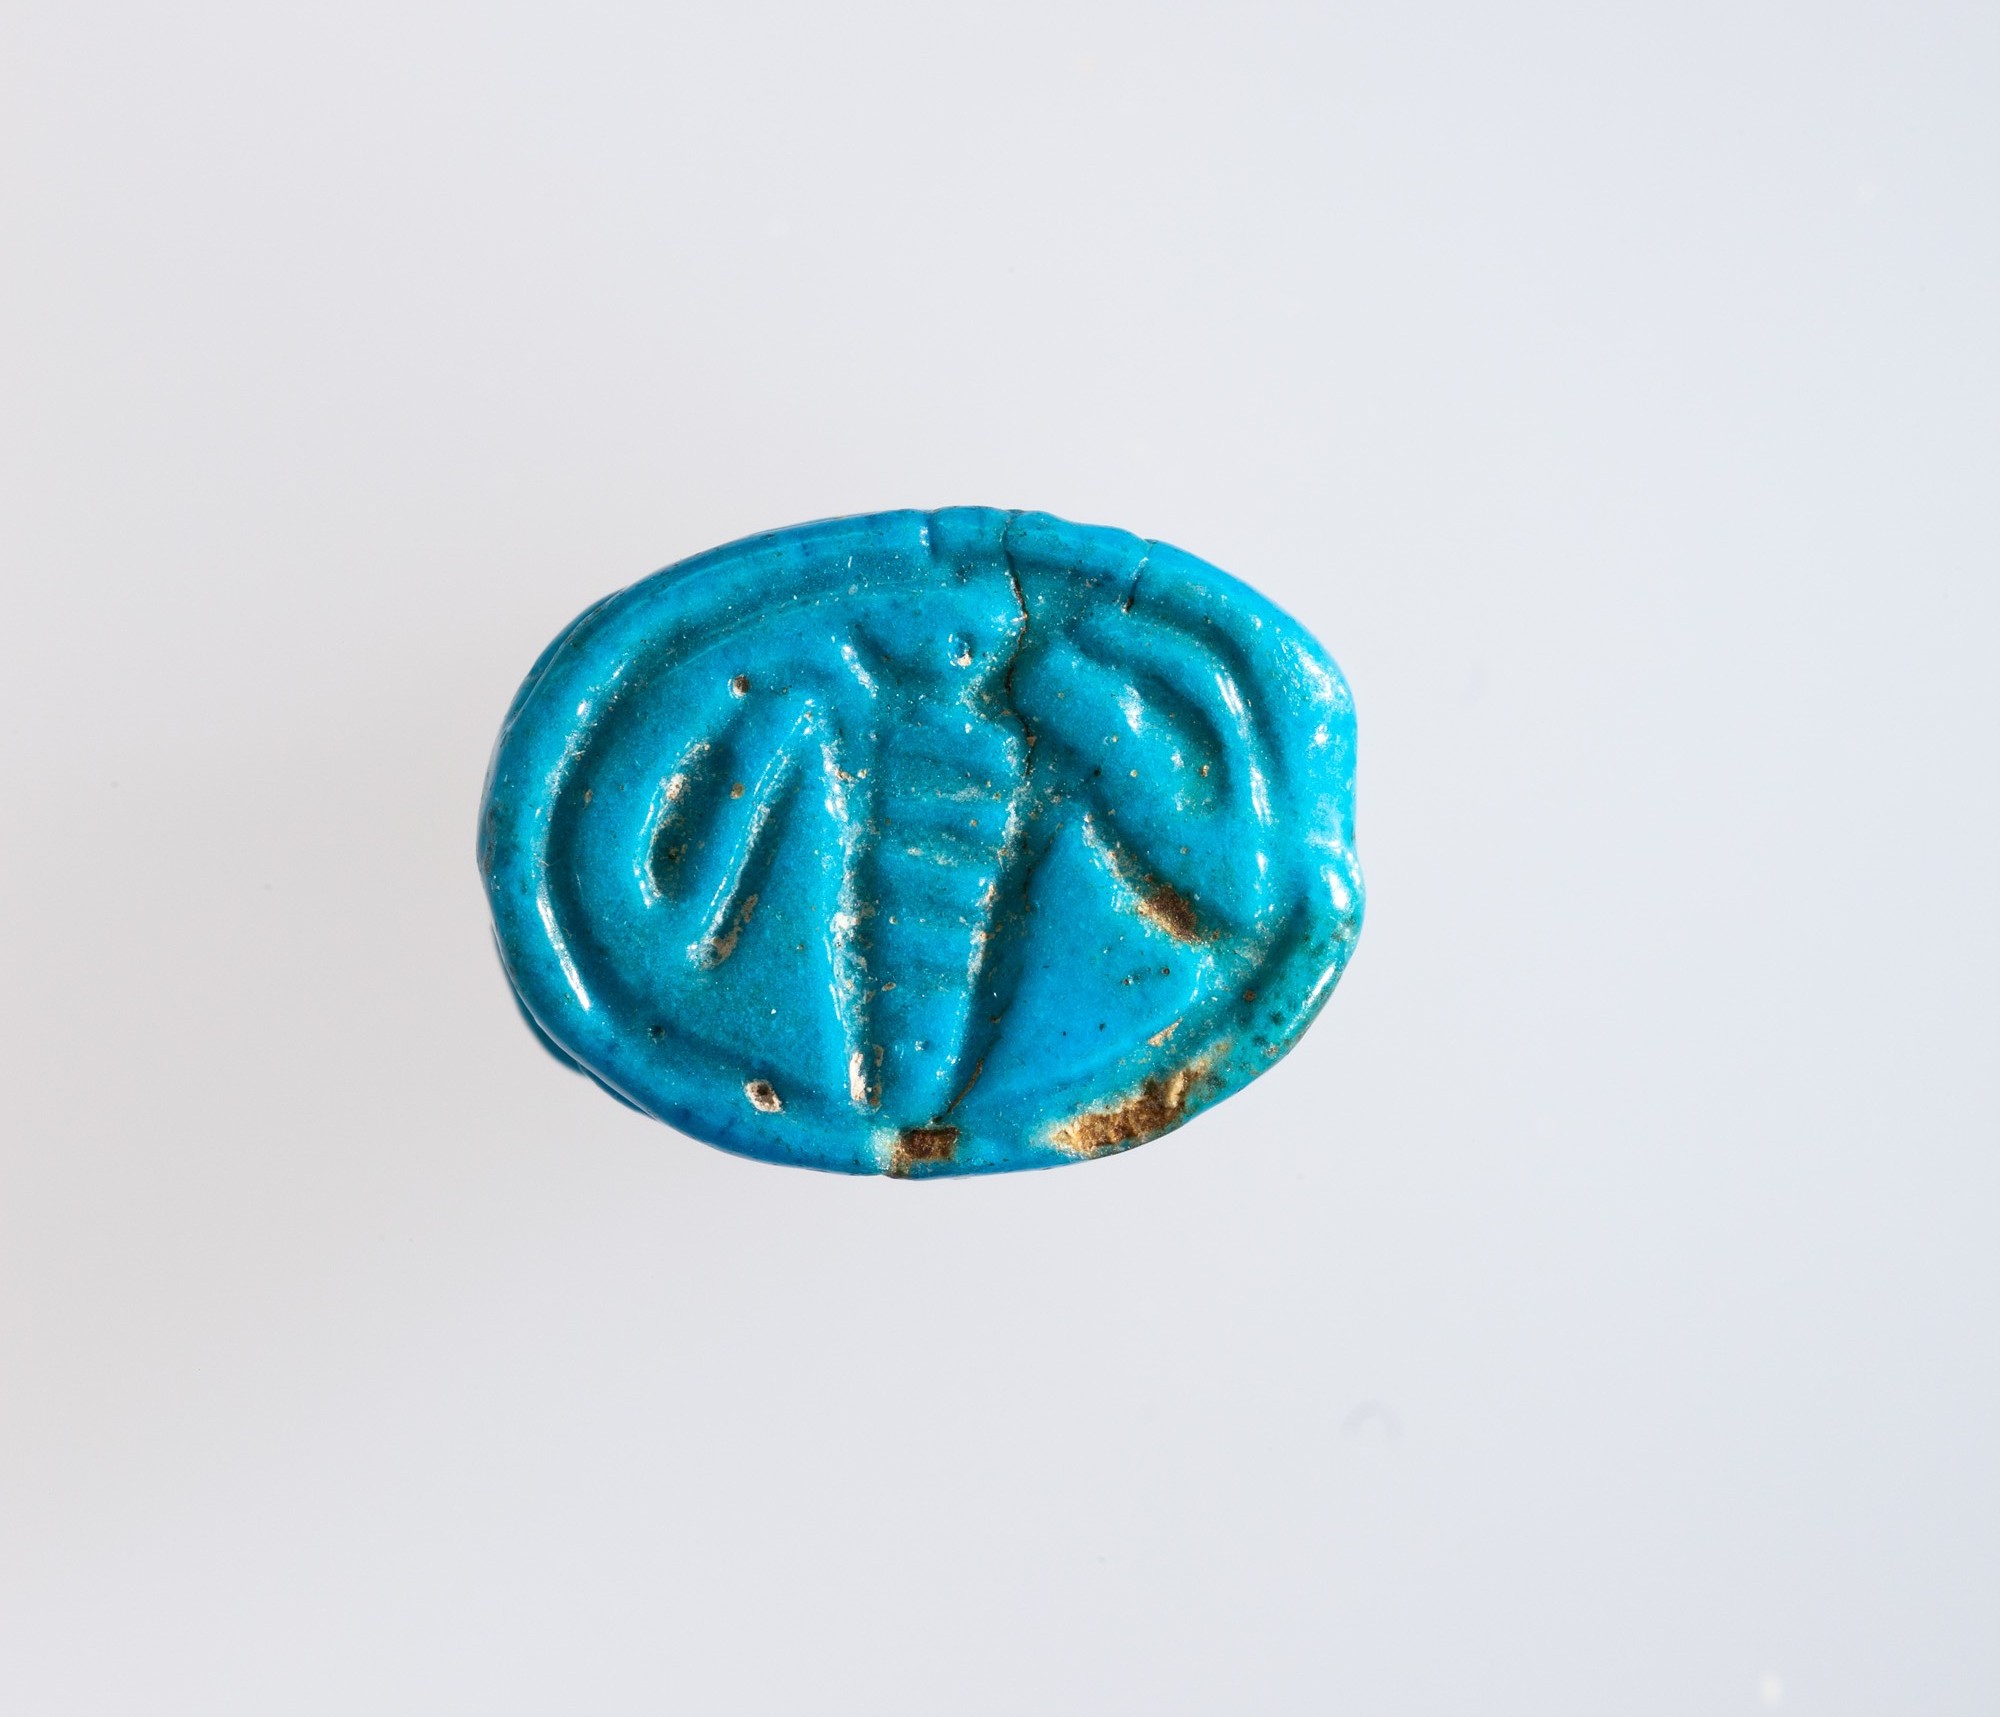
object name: scarab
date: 1479-1458 BCE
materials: faience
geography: egypt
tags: scarabs